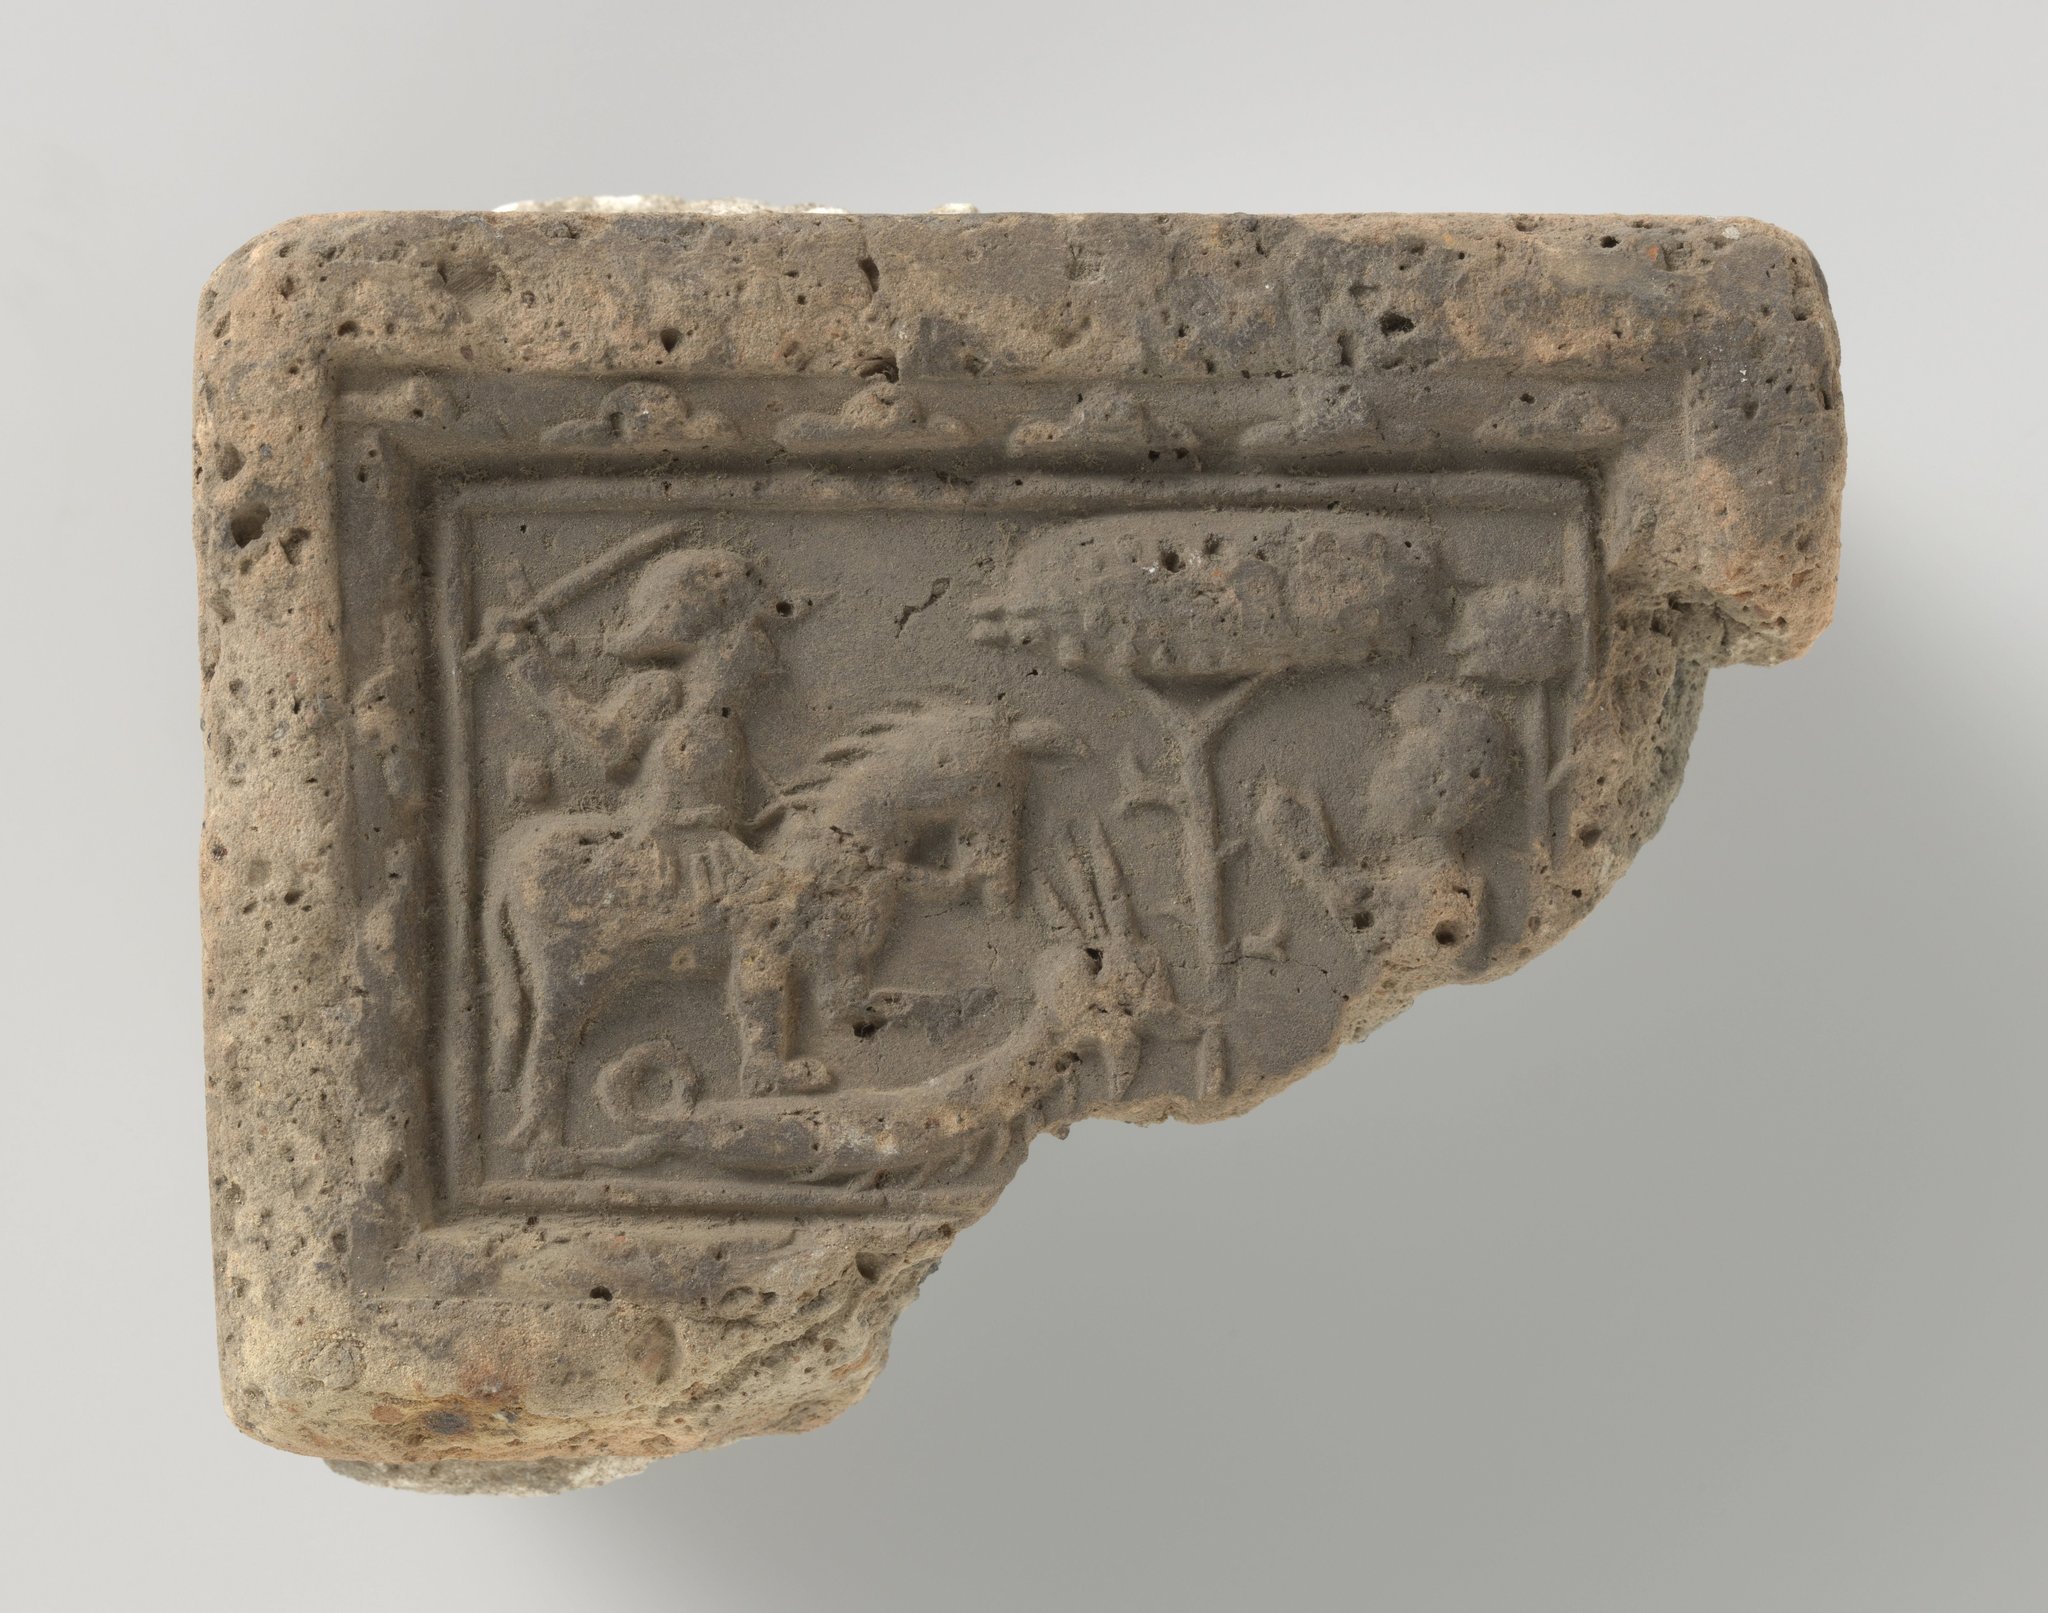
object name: hearthstone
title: Haardsteen met voorstelling van Sint Joris te paard, die de draak doodt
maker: Anonymous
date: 1525-1550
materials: earthenware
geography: southern netherlands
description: Haardsteen met voorstelling van Sint Joris te paard, die de draak doodt, met rechts de prinses. Rondom de voorstelling een gedecoreerde rand. Rechteronderhoek en delen van de achterzijde ontbreken.